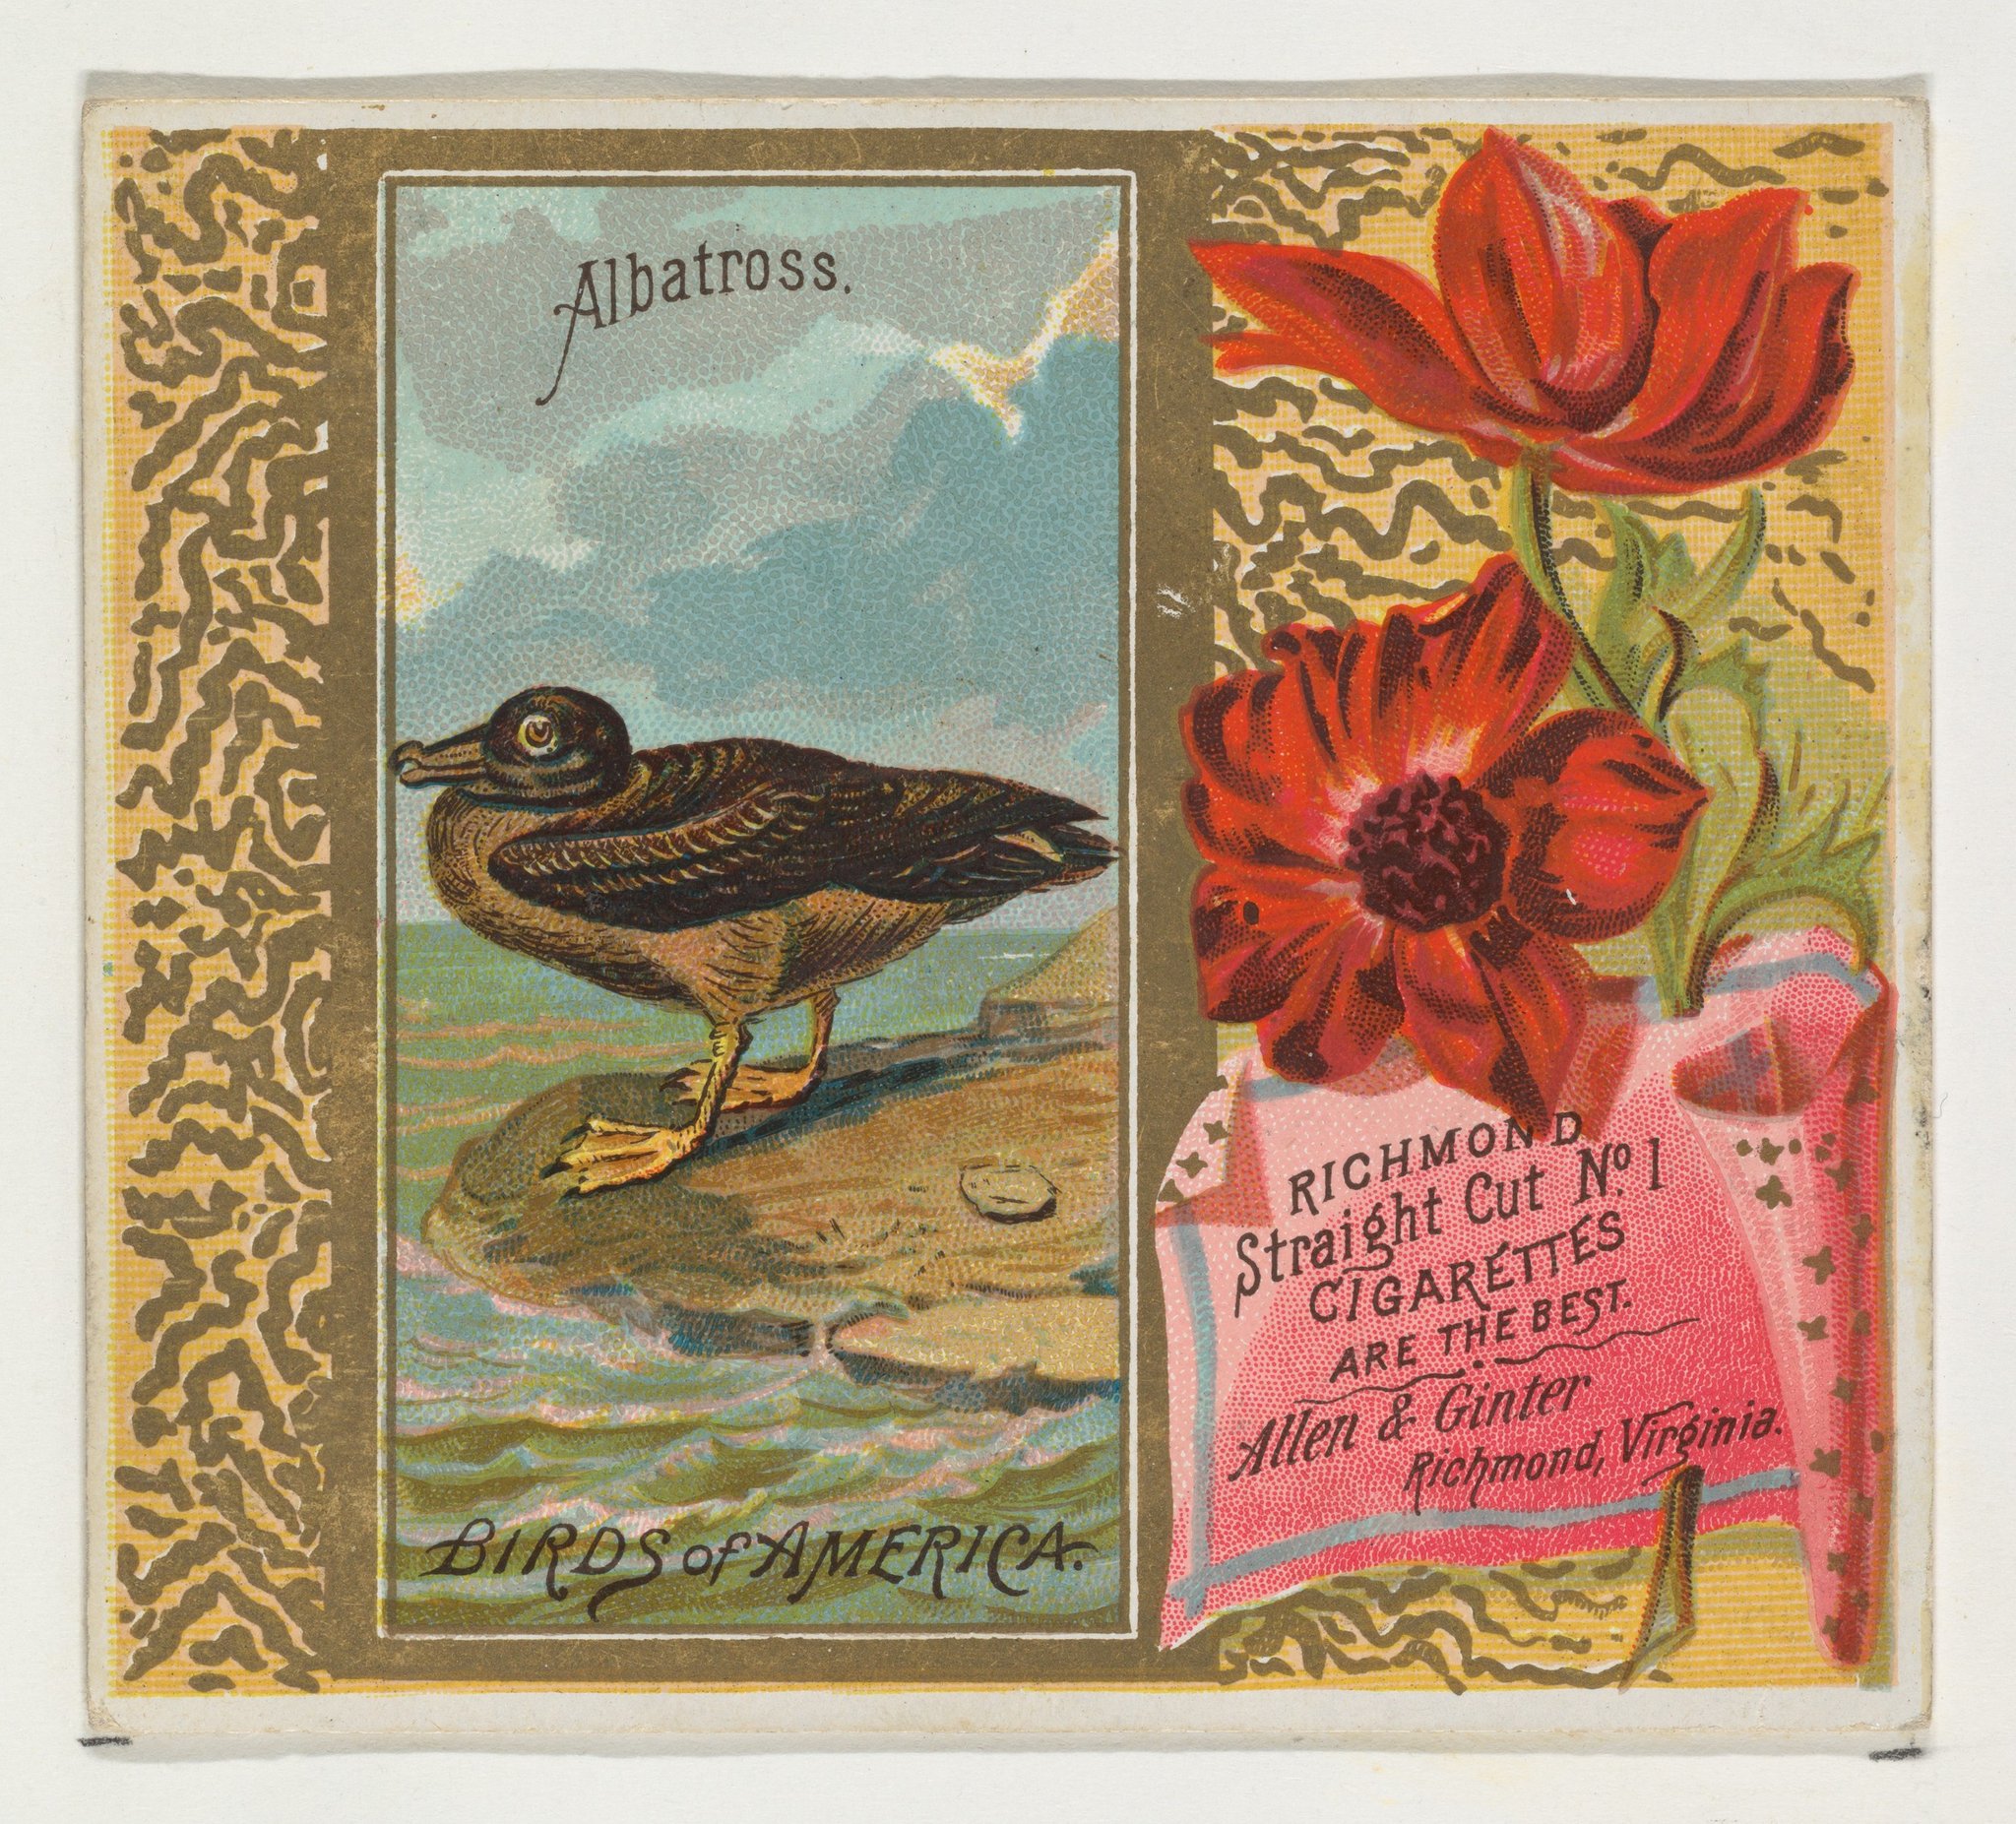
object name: print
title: Albatross, from the Birds of America series (N37) for Allen & Ginter Cigarettes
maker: allen & ginter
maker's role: publisher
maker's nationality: american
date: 1888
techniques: color lithograph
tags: birds,flowers